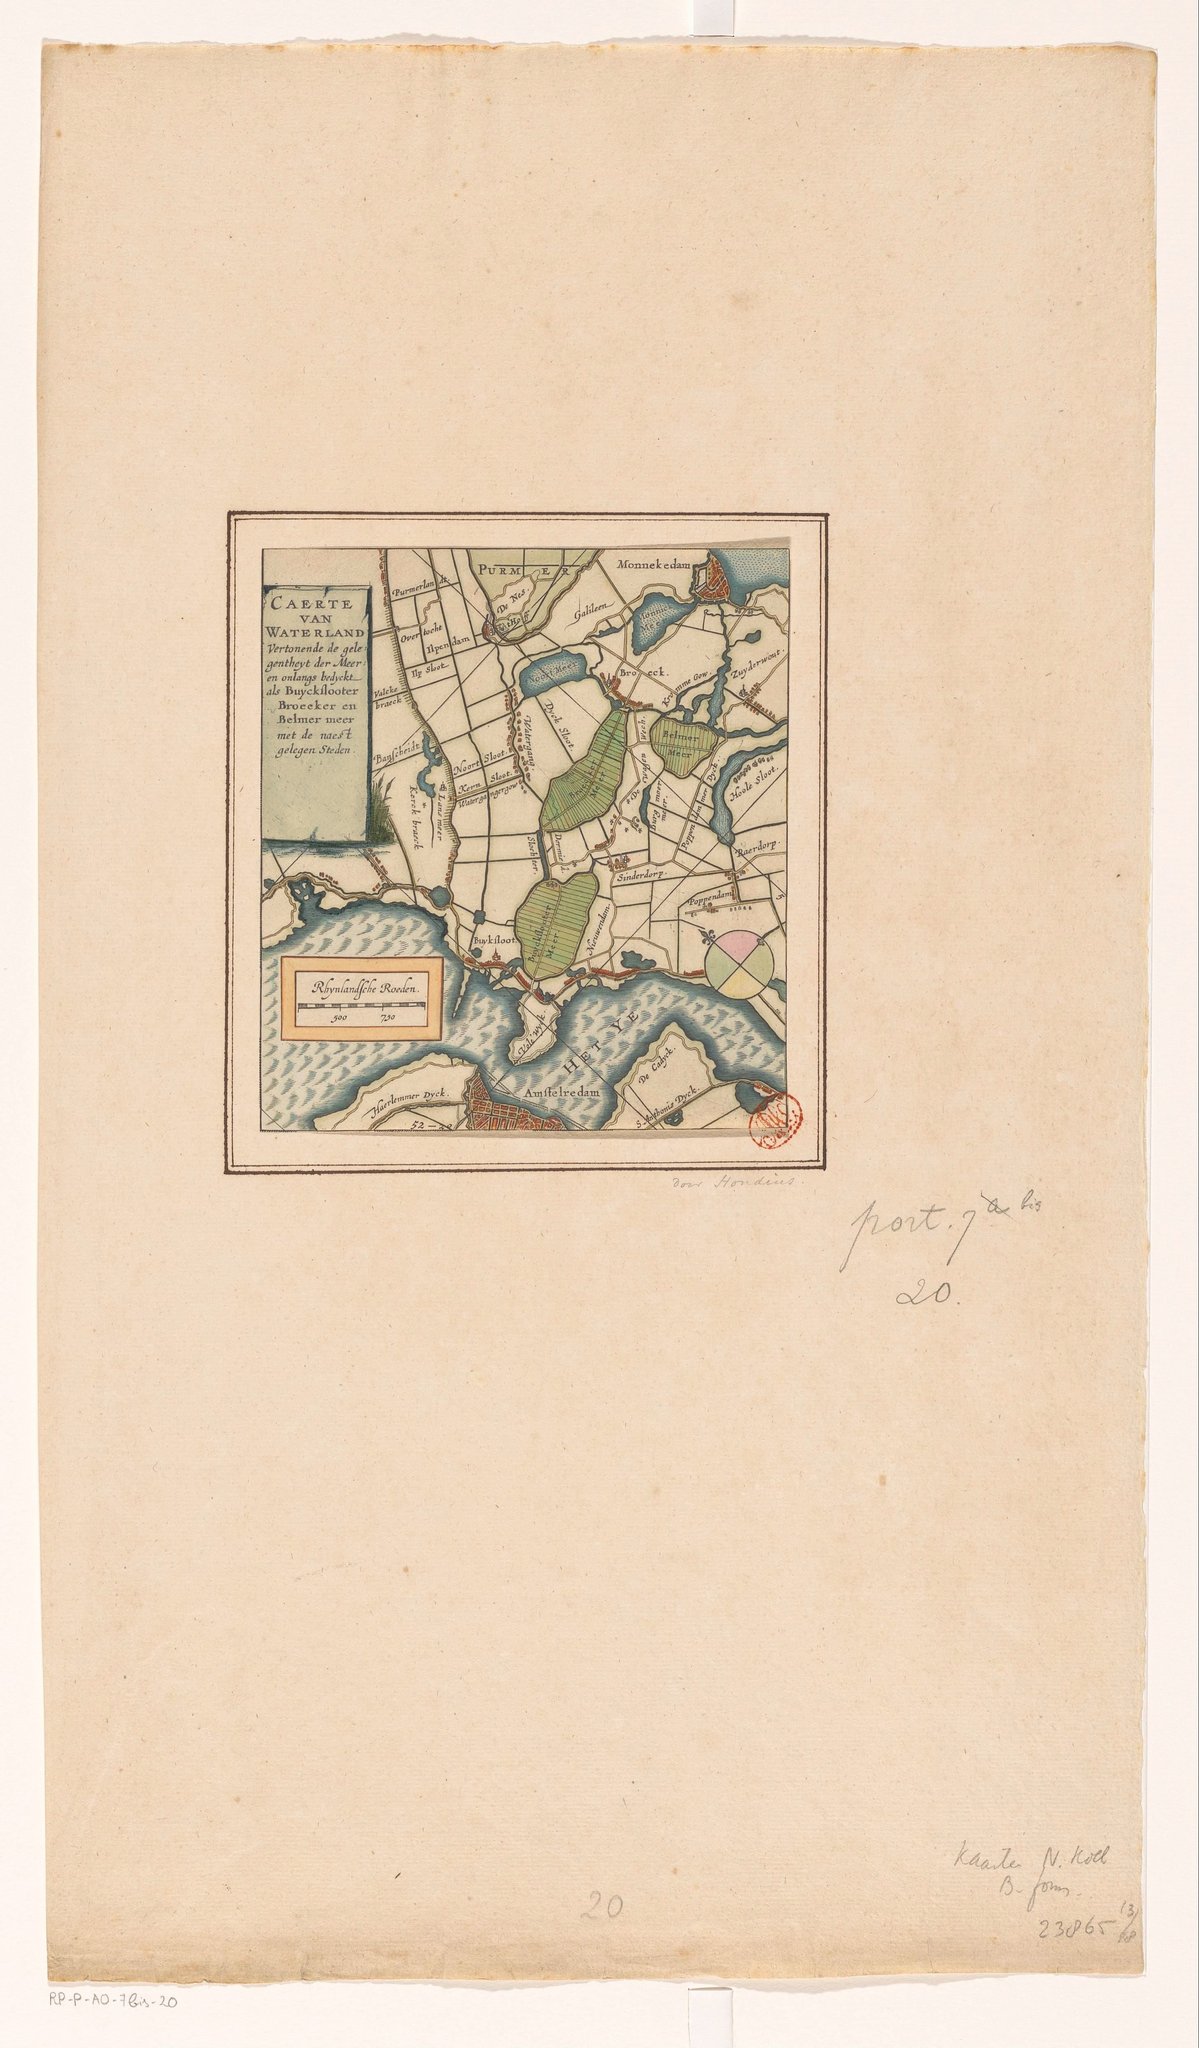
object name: map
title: Caerte van Waterland vertonende de gelegentheyt der meer: en onlangs bedyckt als Buyckslooter Broecker en Belmer meer met de naest gelegen steden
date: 1631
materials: paper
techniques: engraving, etching, hand coloring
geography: amsterdam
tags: maps of separate countries or regions, polder, reclaimed land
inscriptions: collector's mark: Lugt 195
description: Deze kaart is afgesneden van een prent met daarop vijf polderkaarten (de Zijpe, de Beemster, de Purmer, de Wormer en Waterland). Voor de eerste staat van de volledige prent zie RP-P-OB-80.778, RP-P-2016-353 en RP-P-AO-7bis-28-2. De huidige kaart is afkomstig van de derde staat van deze prent (zie RP-P-AO-7bis-28-1), die ook gebruikt is in: The English Atlas. 4 delen. Oxford en Amsterdam: Moses Pitt, Johannes Janssonius van Waesbergen (I), Johannes Janssonius van Waesbergen (II) en Steven Swart, 1680-1683, dl. 4 (Moses Pitt, Johannes Janssonius van Waesbergen (I), en Steven Swart, 1682).